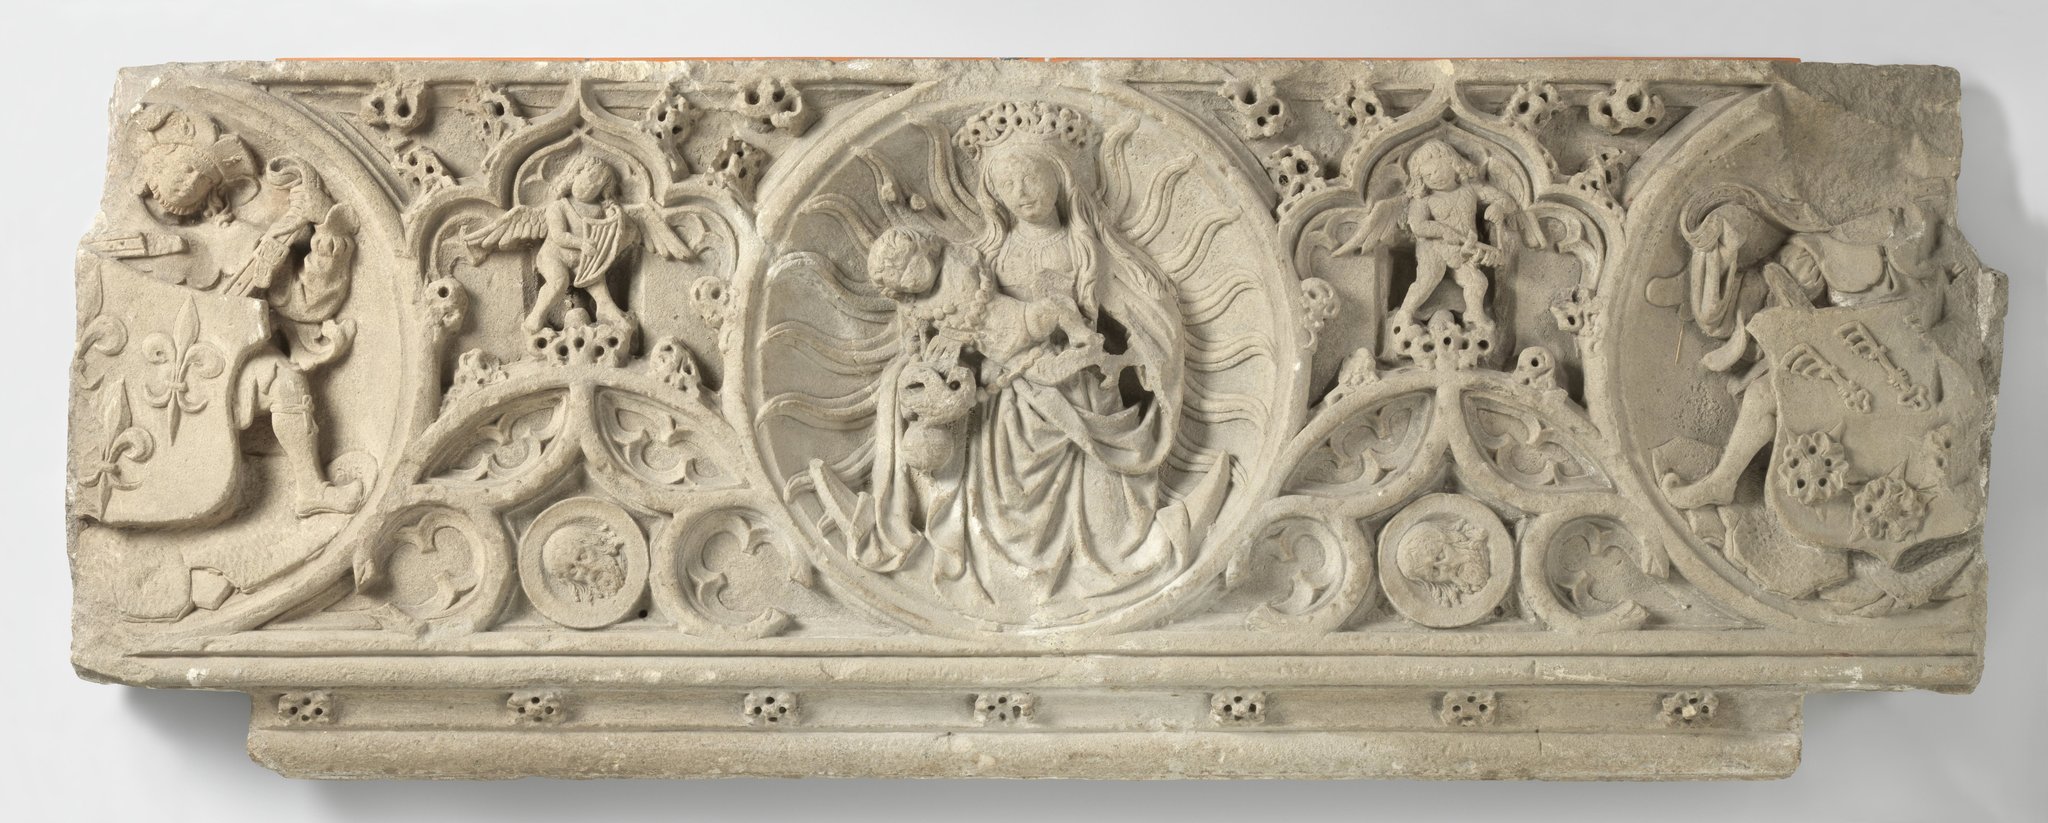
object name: schoorsteenfries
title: Virgin and Child Flanked by Two Shield-Bearers, Fragment of a Frieze from a Chimney-Piece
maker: Anonymous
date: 1510-1520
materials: stone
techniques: hewing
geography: utrecht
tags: madonna on the crescent of the moon (sometimes called queen of heaven) (in mandorla), john the baptist; possible attributes: book, reed cross, baptismal cup, honeycomb, lamb, staff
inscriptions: coat of arms, on the escutcheon, at the right, in relief: parted per fess, 1. three keys; 2. three roses (? Lam family), coat of arms, on the escutcheon, at the left, in relief: three fleur de lis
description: Frieze of a chimney-piece. The Virgin and Child. Sandstone. Utrecht, c. 1510.